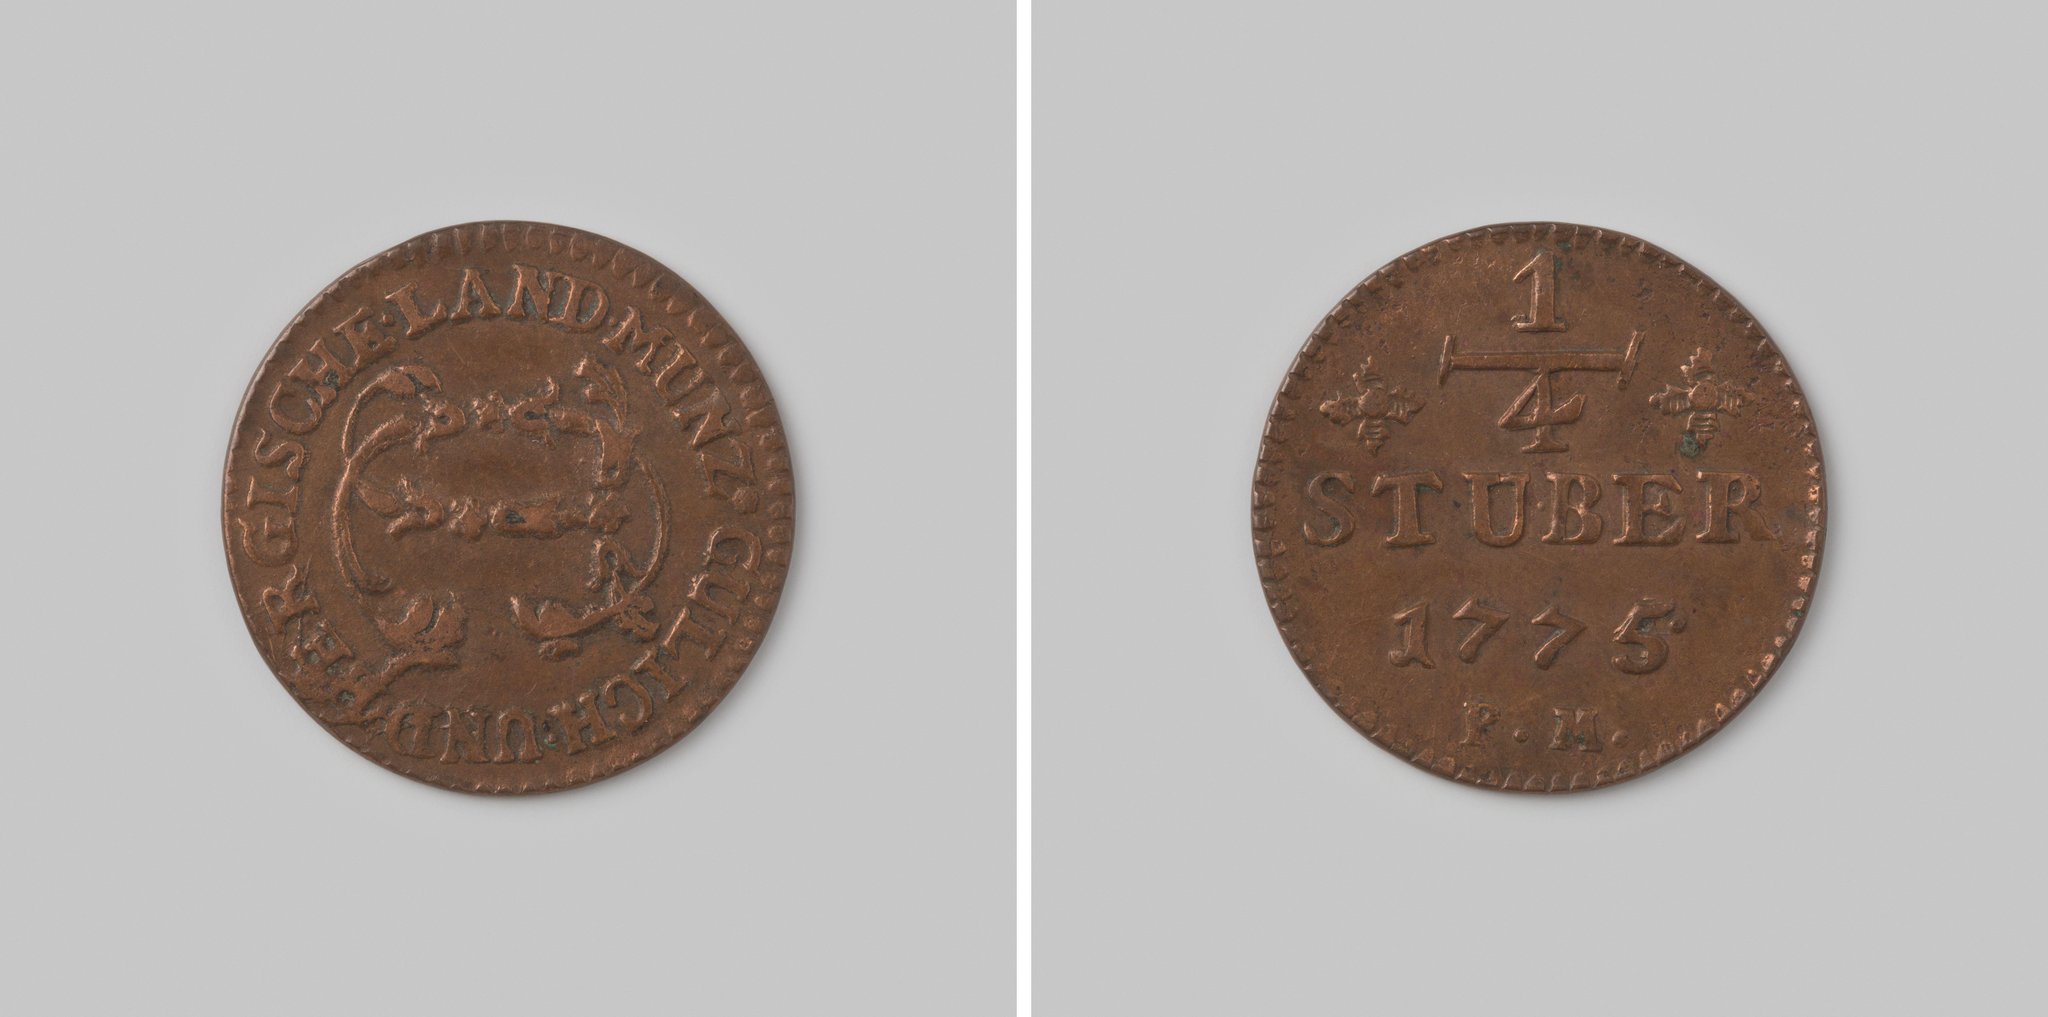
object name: coin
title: 1/4 Stüber uit Julich-Berg van Karl Theodor,1775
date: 1775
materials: copper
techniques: striking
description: Koperen munt. Voorzijde: monogram, bestaande uit de letters C en T. Keerzijde: waarde-aanduiding in twee regels, waaronder jaartal. Gladde rand.